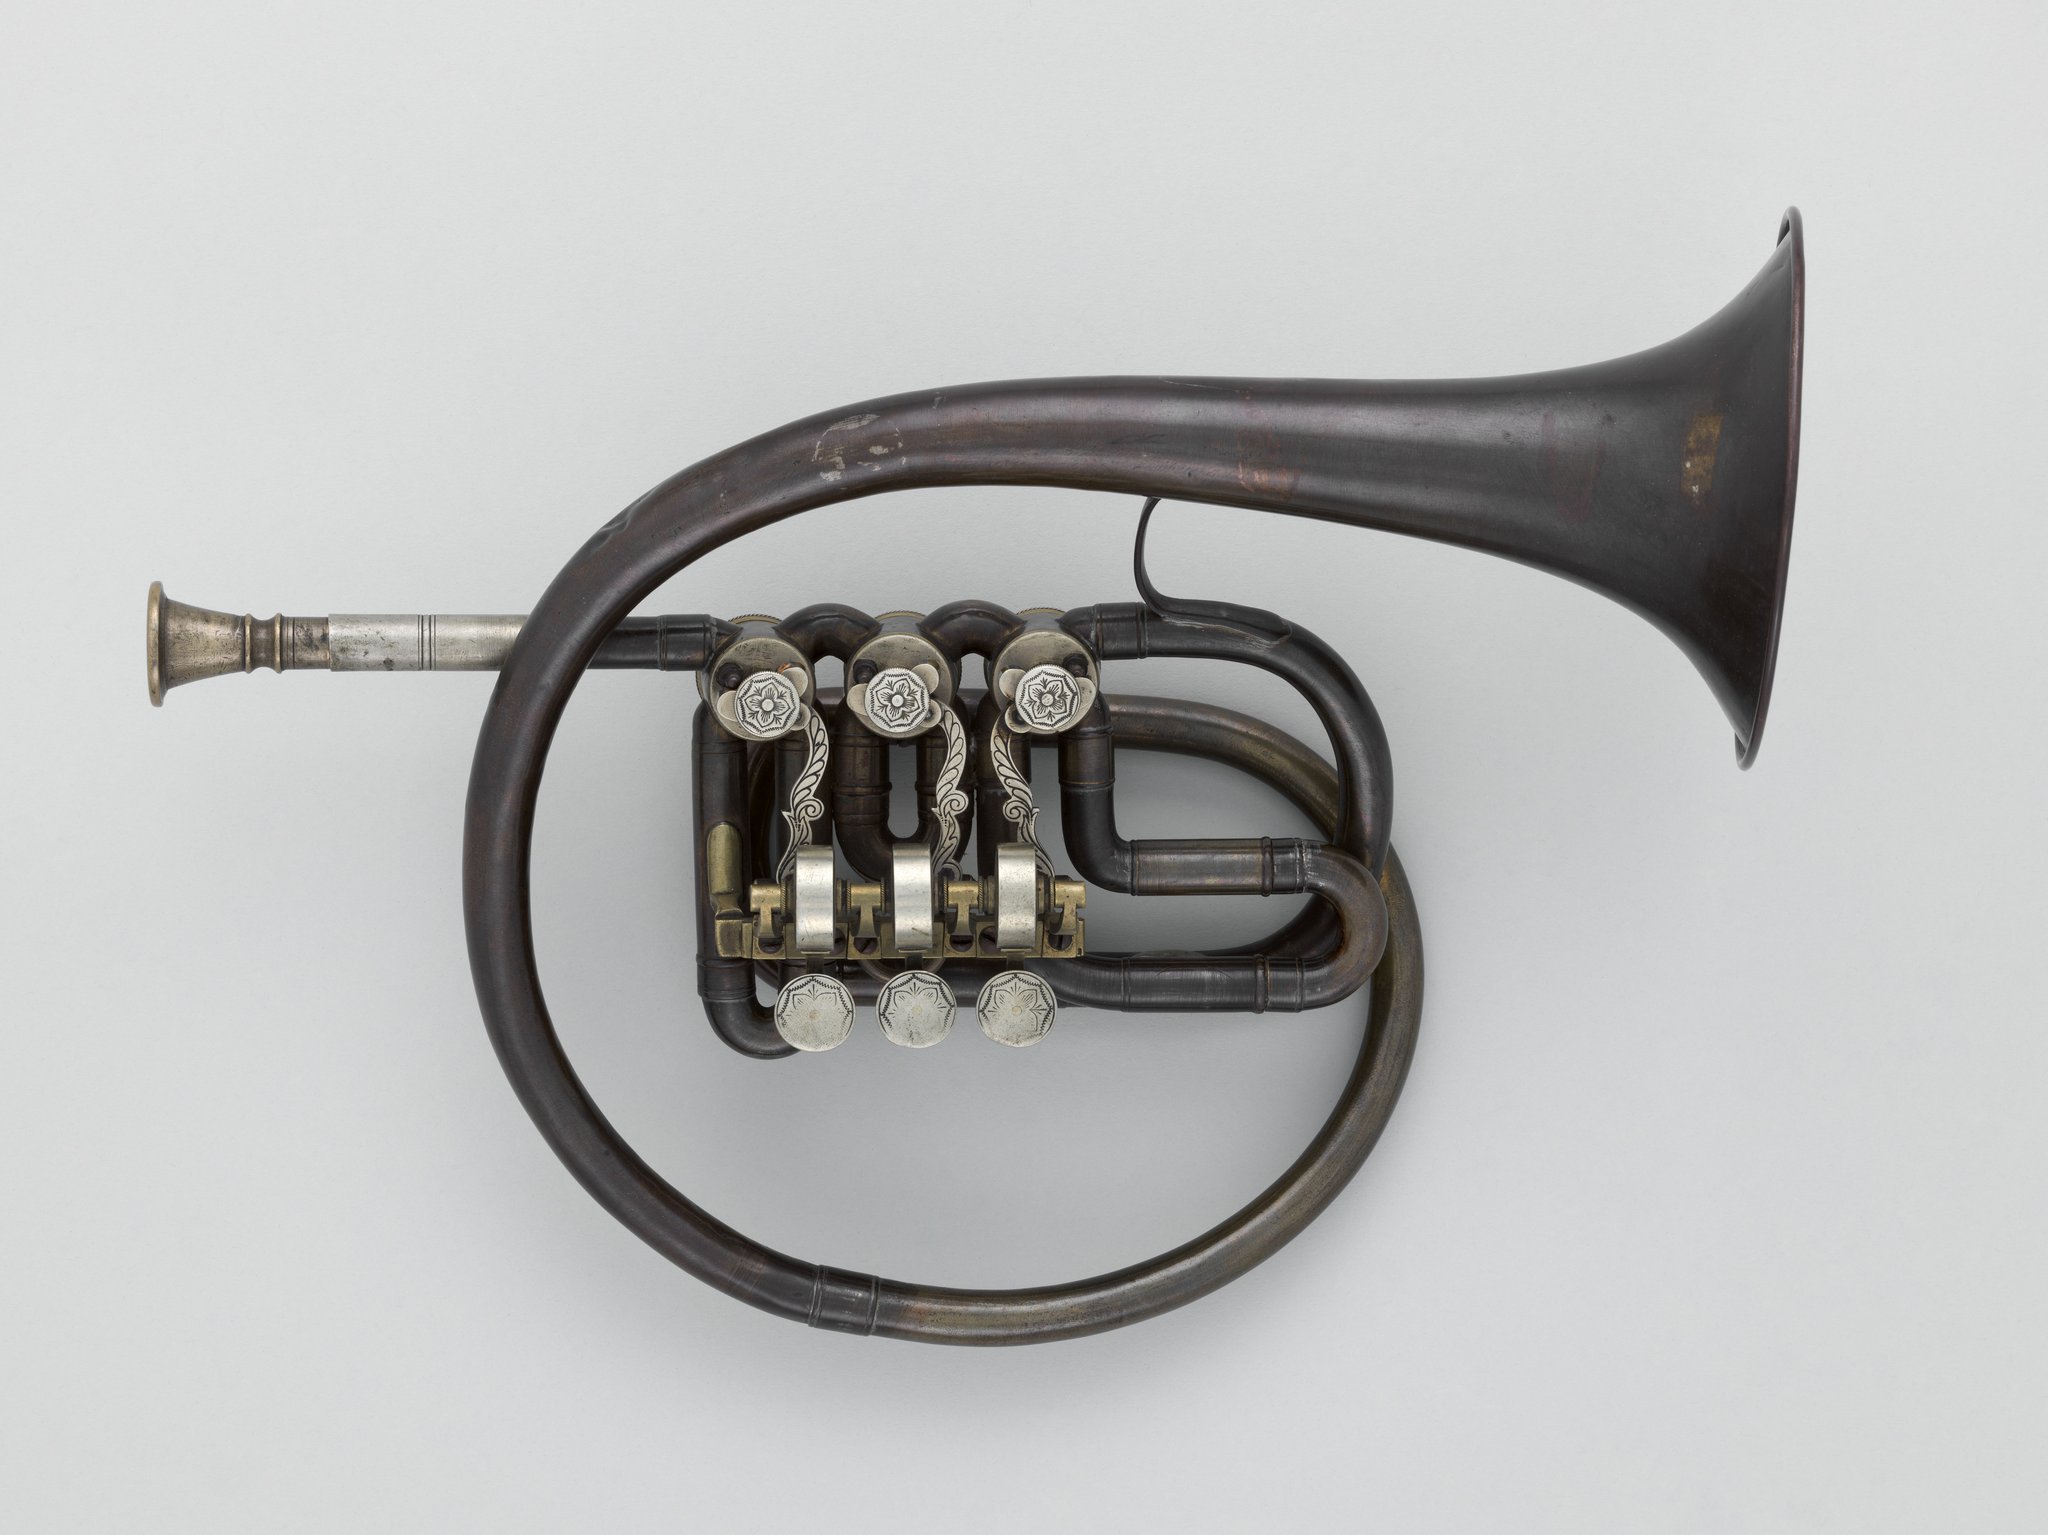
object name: circular trumpet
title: Soprano Helicon in B-flat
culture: italian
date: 1834-1866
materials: brass, nickel, silver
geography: italy